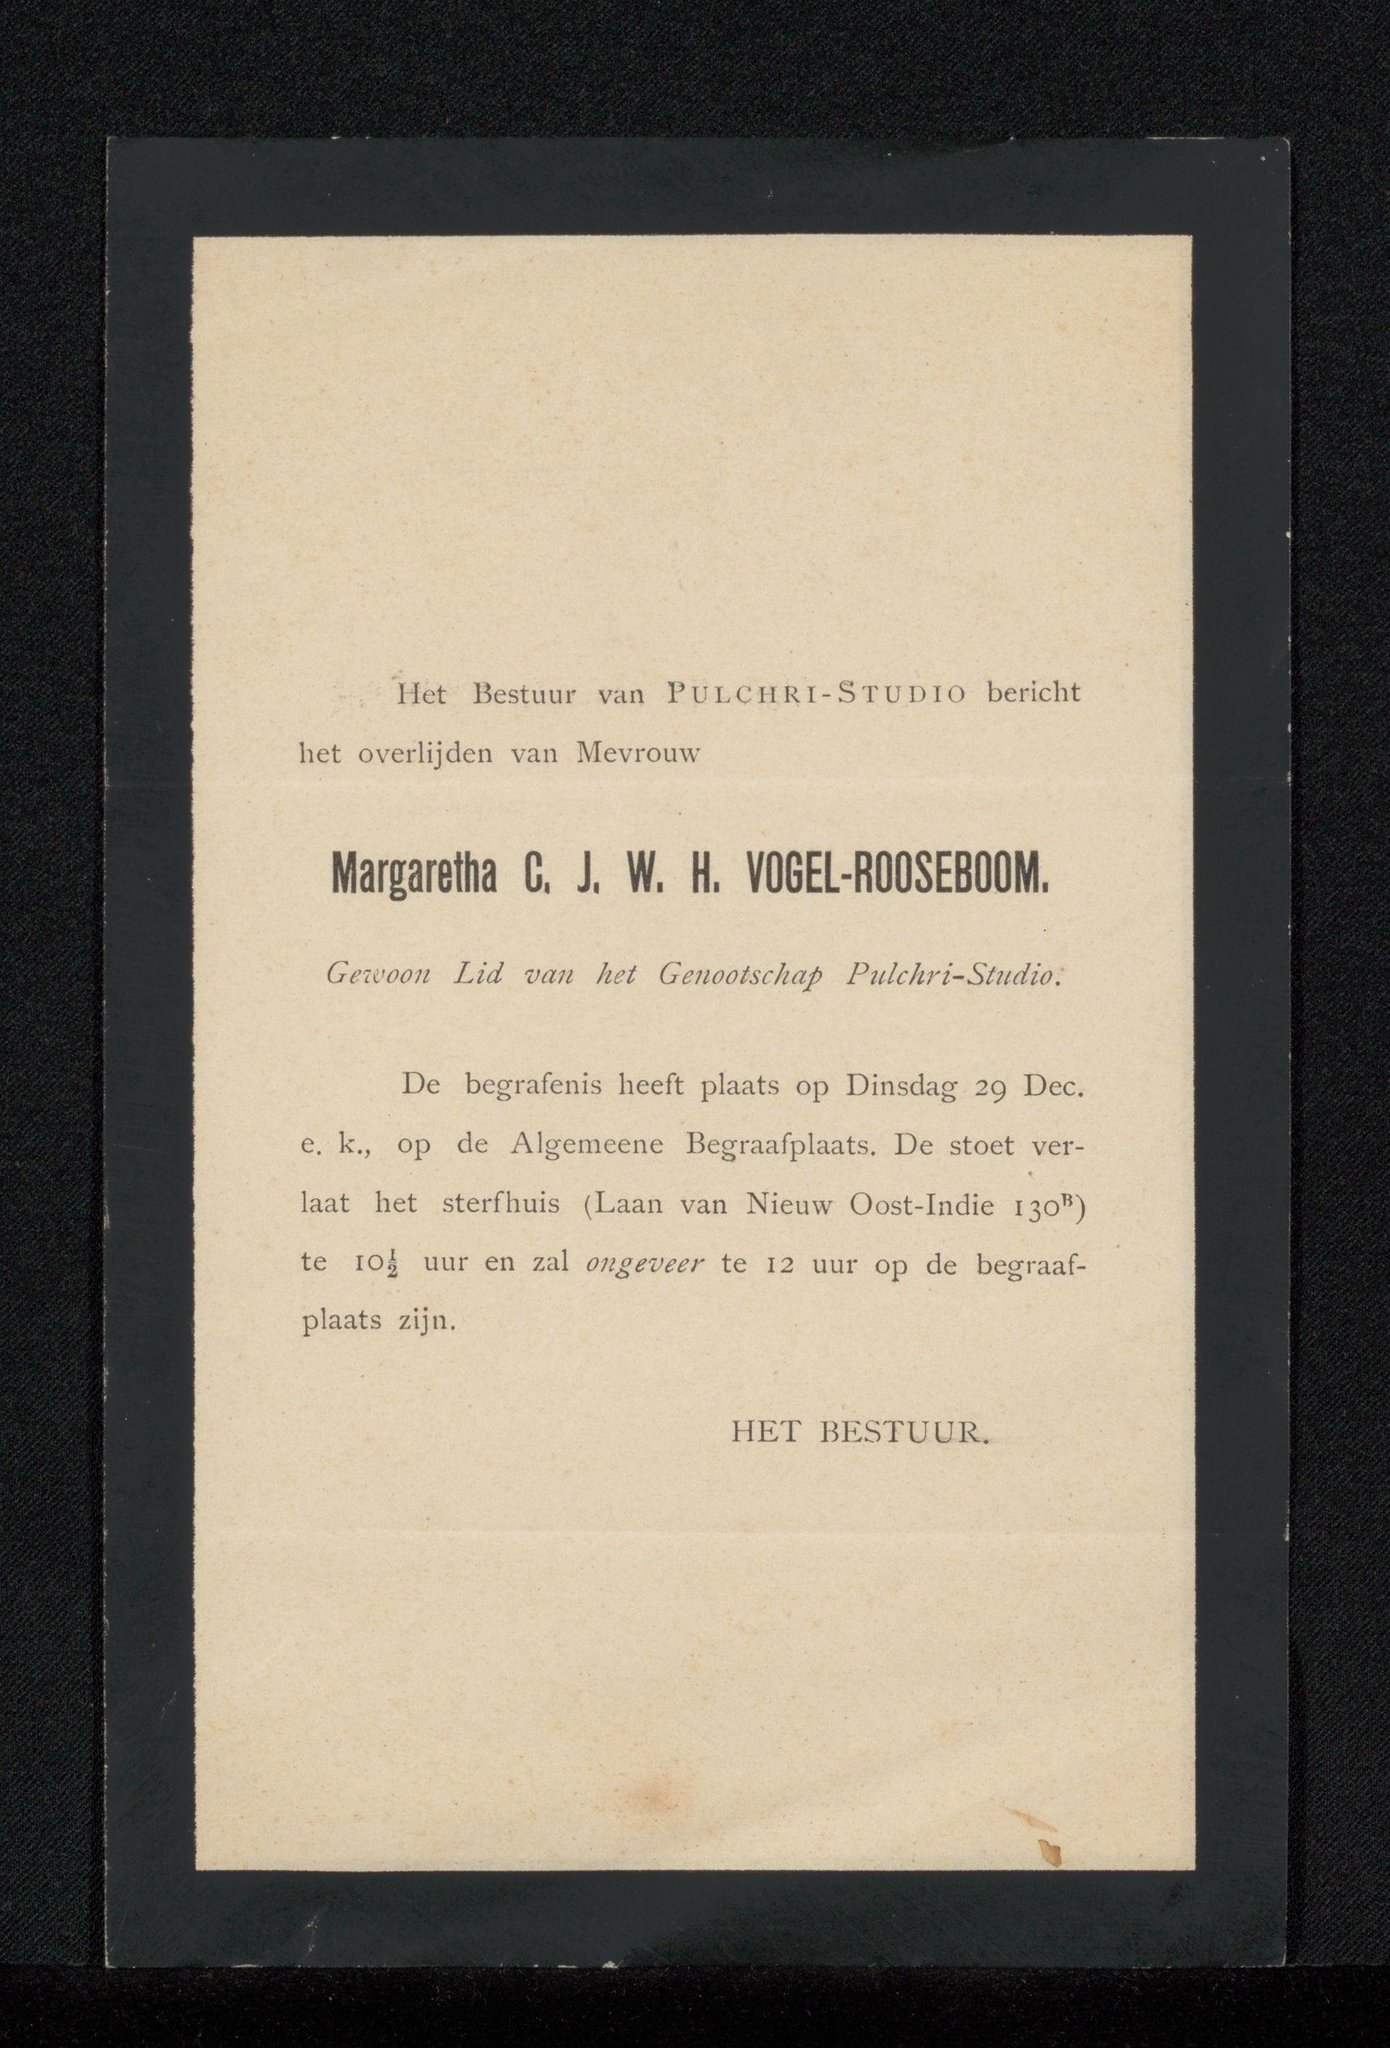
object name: overlijdensbericht, overlijdensadvertentie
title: Overlijdensbericht aan Philip Zilcken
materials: ink, paper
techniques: pen, printing, writing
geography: the hague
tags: voorburg, painter, draughtsman, margaretha roosenboom, philip zilcken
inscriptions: collector's mark: ‘RPK’